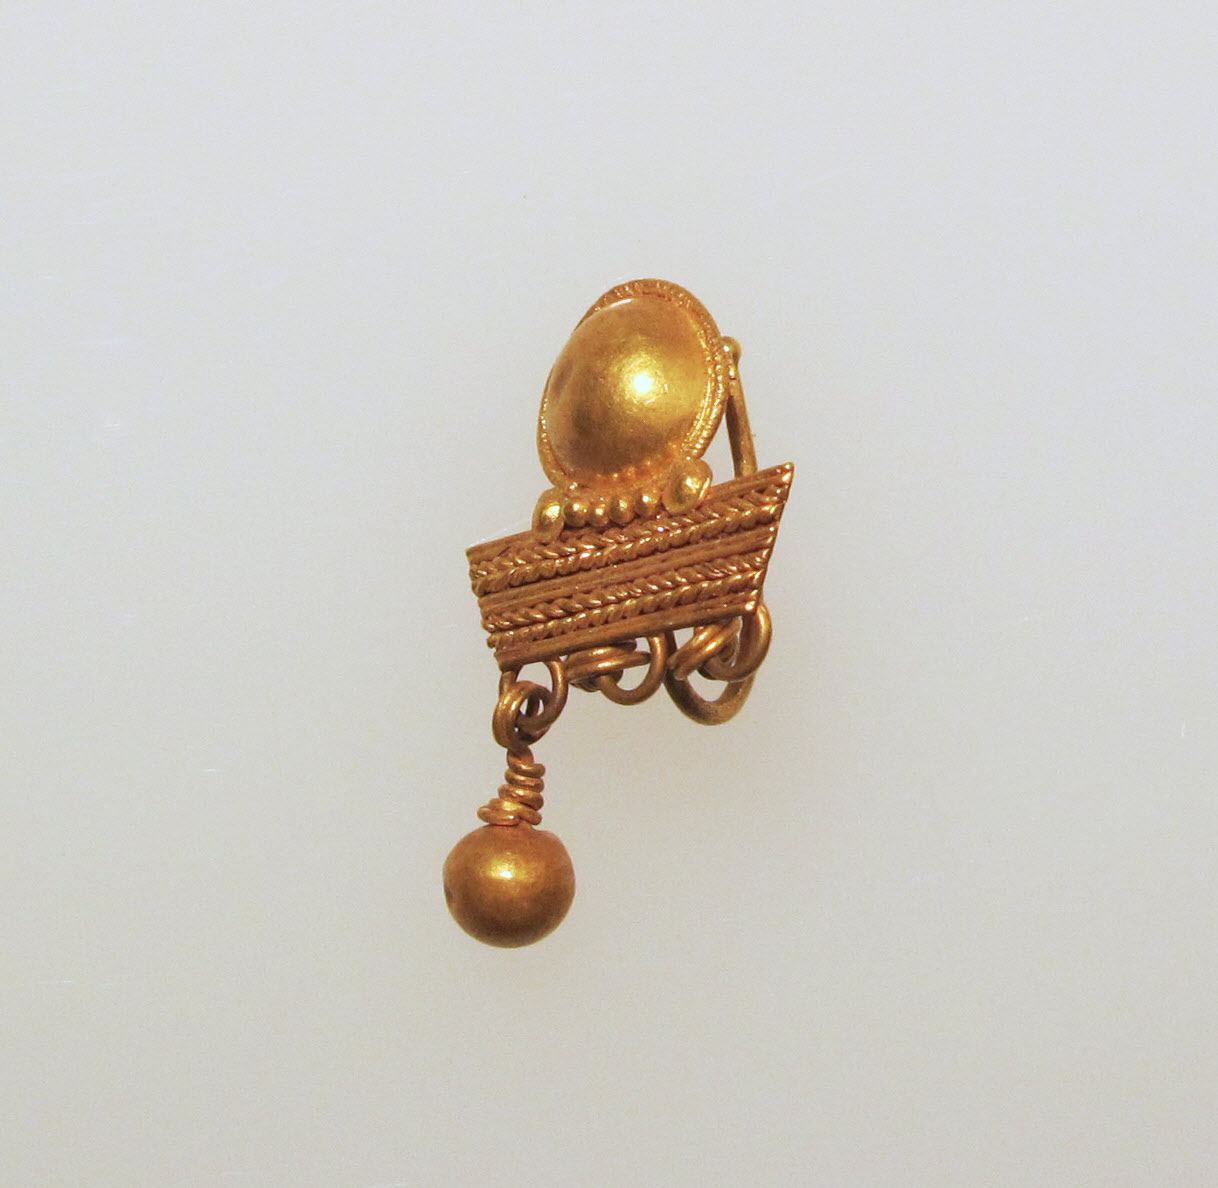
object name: earring hook type with pendant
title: Earring-hook type with pendants and disc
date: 7000 BCE-330 CE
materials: gold